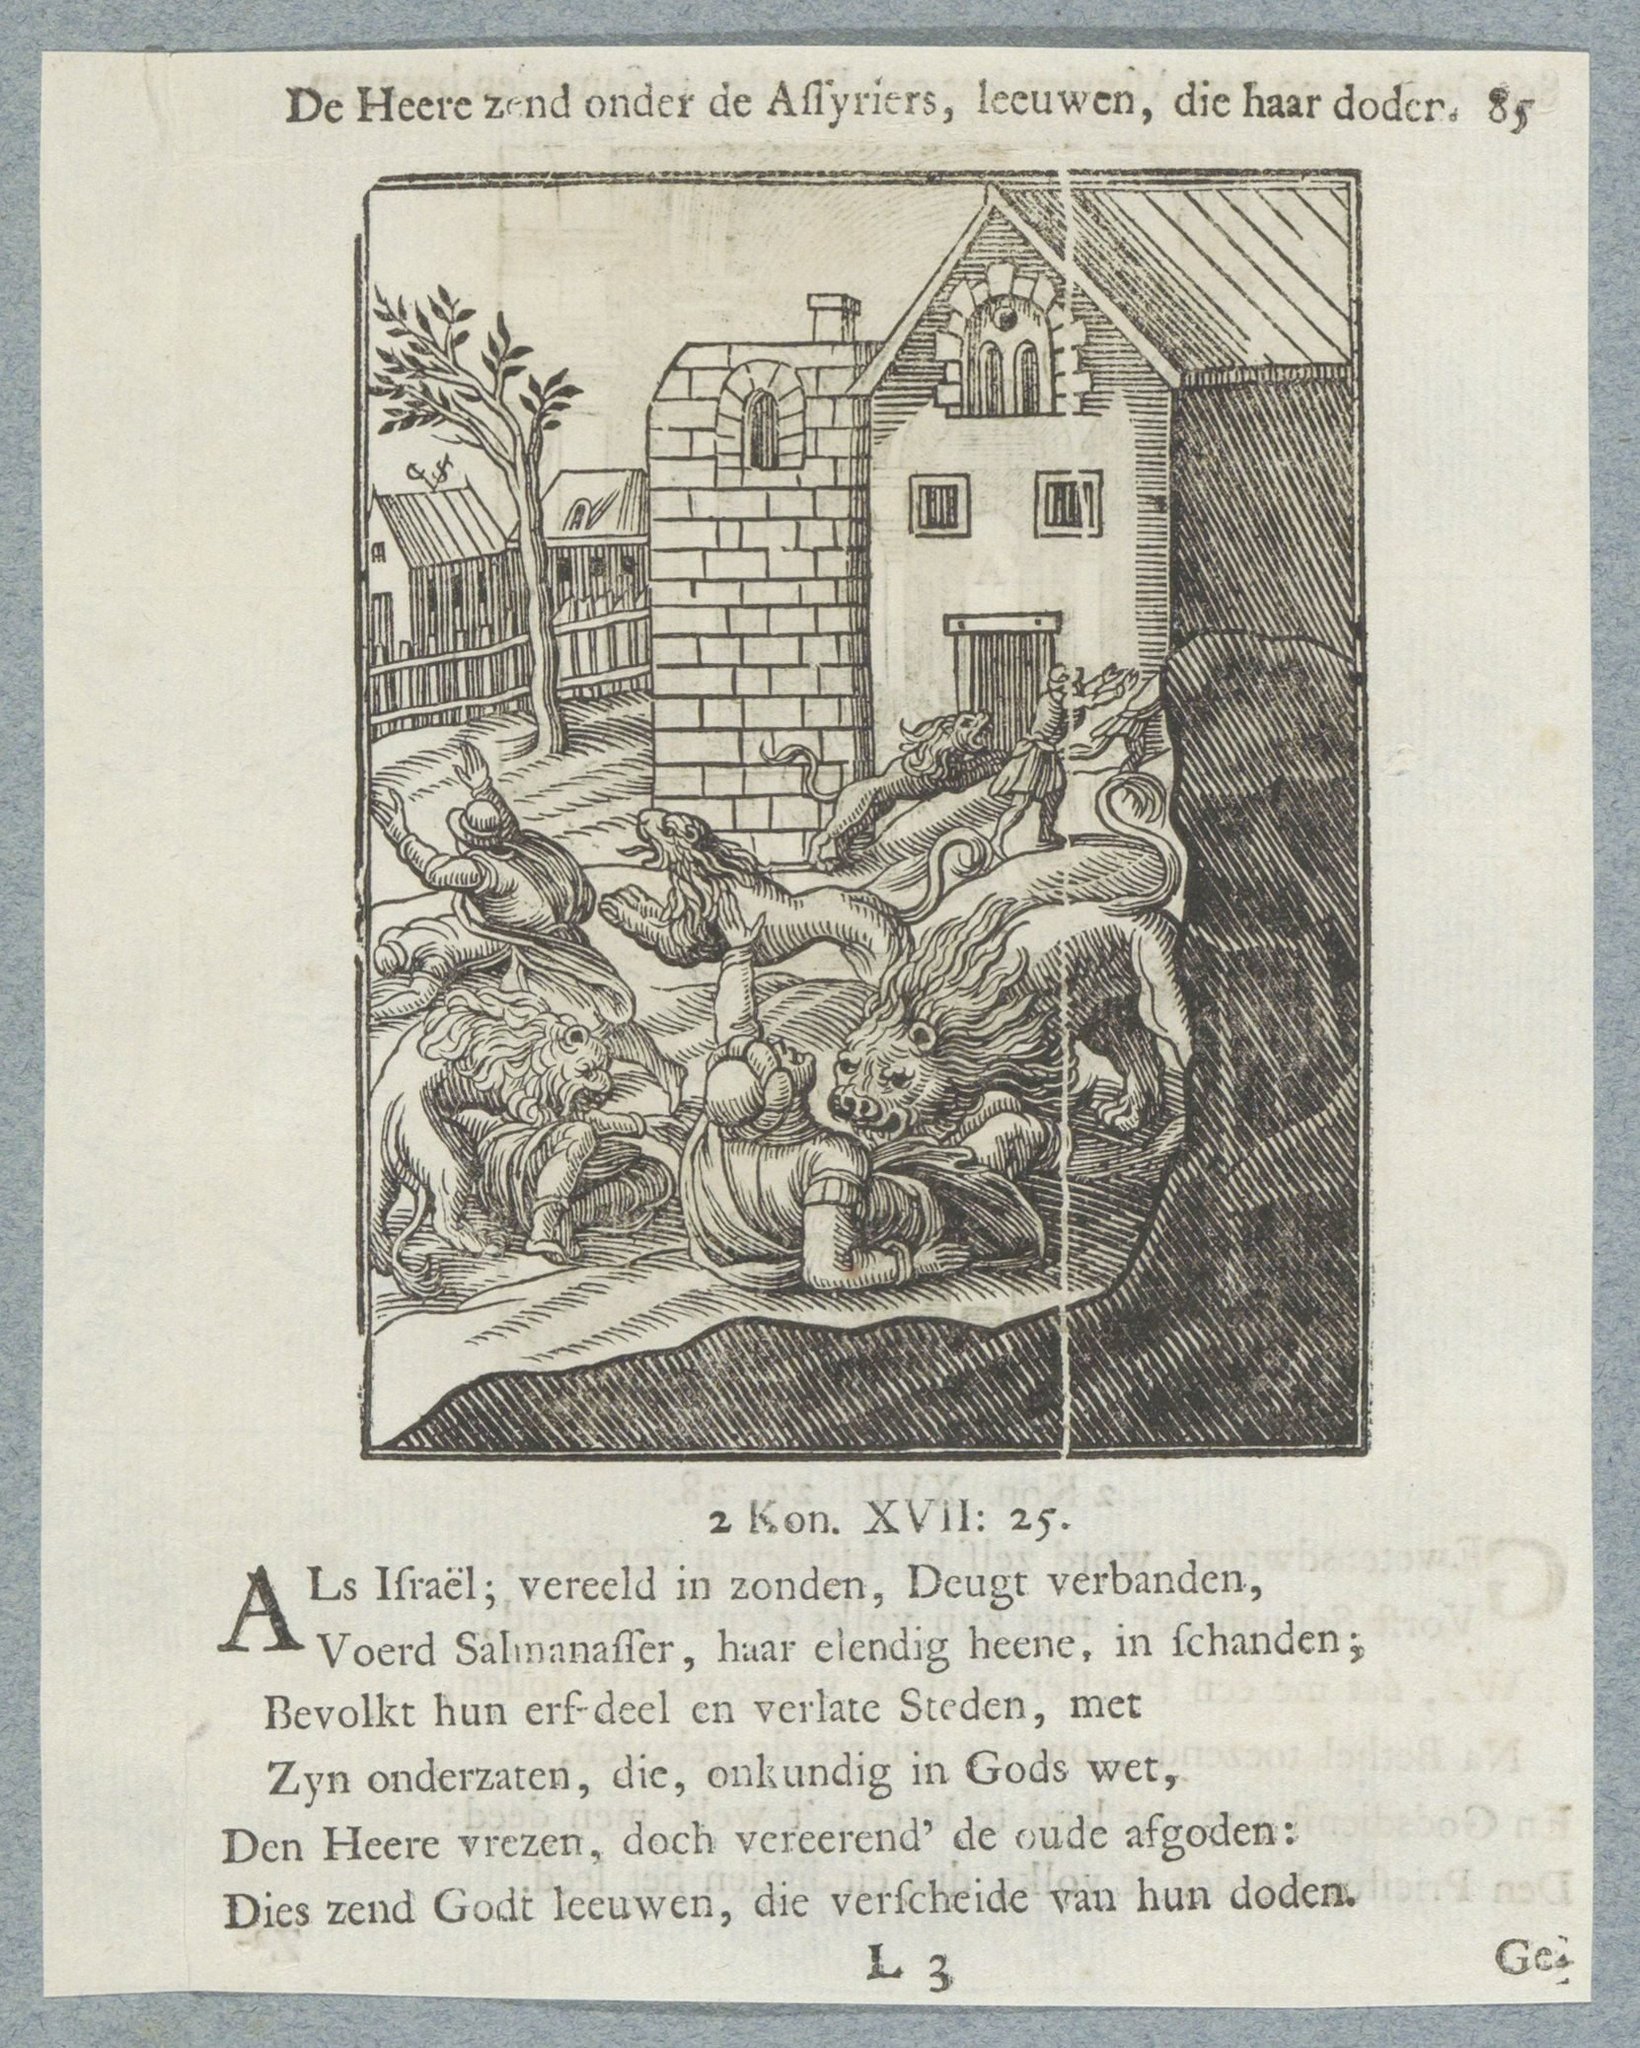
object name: print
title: De Heere zend onder de Assyriers, leeuwen, die haar doden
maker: jan klooster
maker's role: bookseller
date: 1645-1646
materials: paper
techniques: letterpress printing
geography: amsterdam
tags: lions sent by god kill some of the new inhabitants of samaria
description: De koning van Assyrië stuurde mensen uit Babel, Kuta, Awwa, Hamat en Sefarwaïm naar de steden van Samaria, waar hij hun een woonplaats toewees in plaats van de Israëlieten. Deze mensen namen Samaria in bezit en gingen er wonen. De eerste tijd dat zij daar woonden, vereerden ze de Heer niet. Daarom liet de Heer leeuwen op hen los, die een aantal van hen verscheurden. Boven de voorstelling een titel. Eronder zes versregels en een verwijzing naar 2 Koningen 17: 25. De prent maakt deel uit van een album.